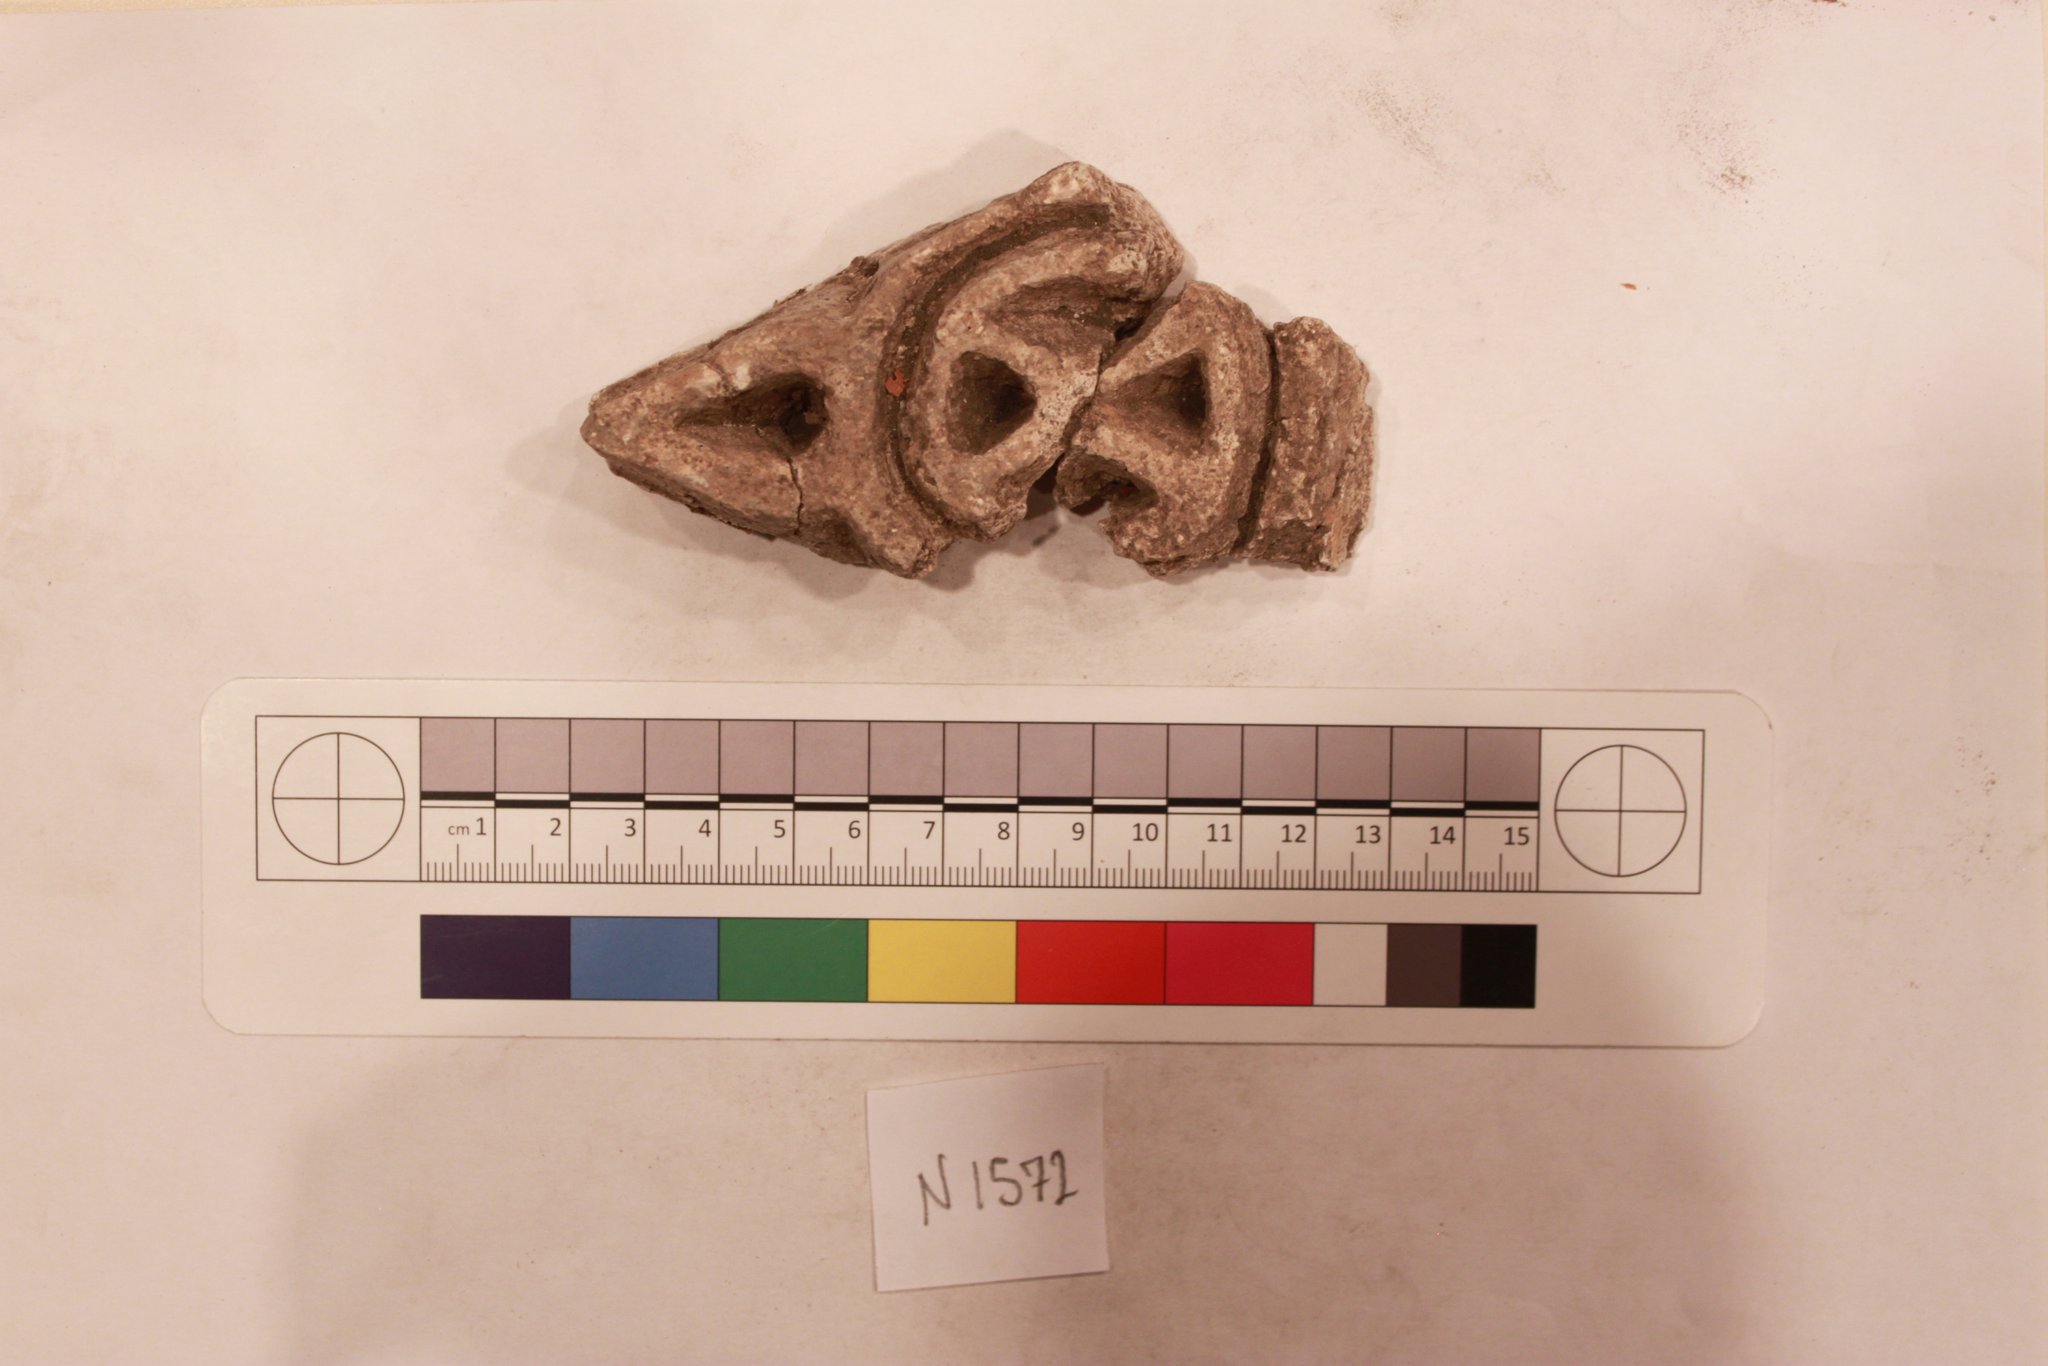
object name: fragment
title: Stucco Fragment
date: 701-1200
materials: plaster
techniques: carving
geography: iran